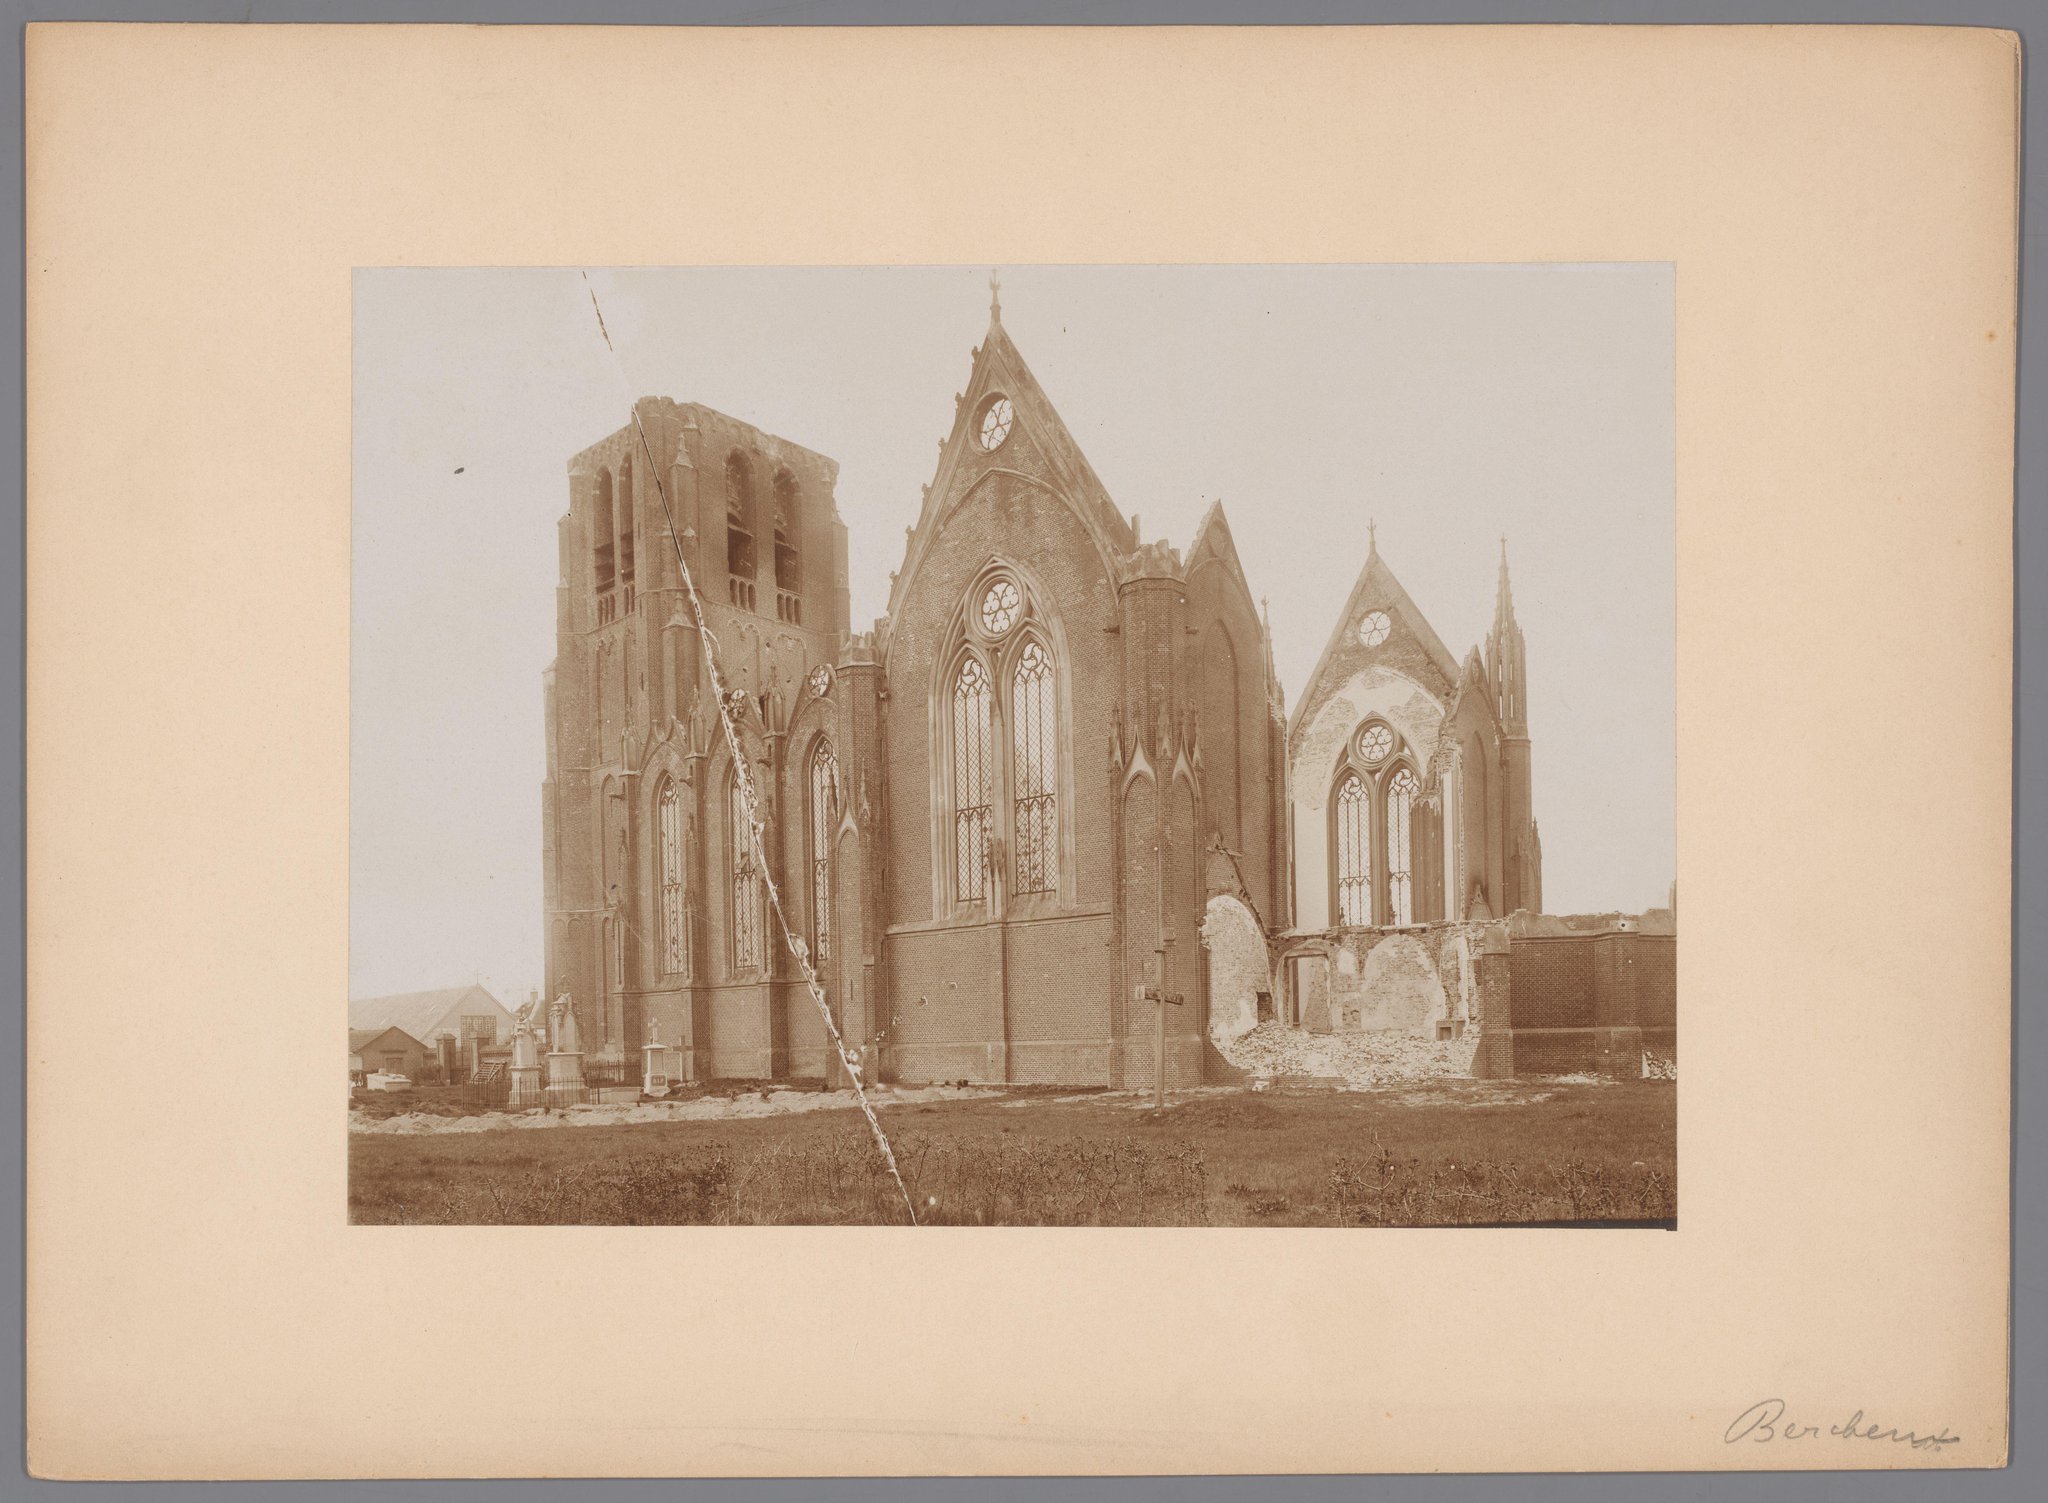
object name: photograph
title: Gezicht op de Rooms-Katholieke Kerk te Berghem na de brand van 1895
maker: anoniem (monumentenzorg)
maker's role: fotograaf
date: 1896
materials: cardboard, photographic support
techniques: gelatin silver print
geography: berghem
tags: ruin of church, monastery, etc.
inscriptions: annotation: ‘Berchem’, annotation: ‘Berchem/ R.K. Kerk na den brand dec 1895/ April 1896’